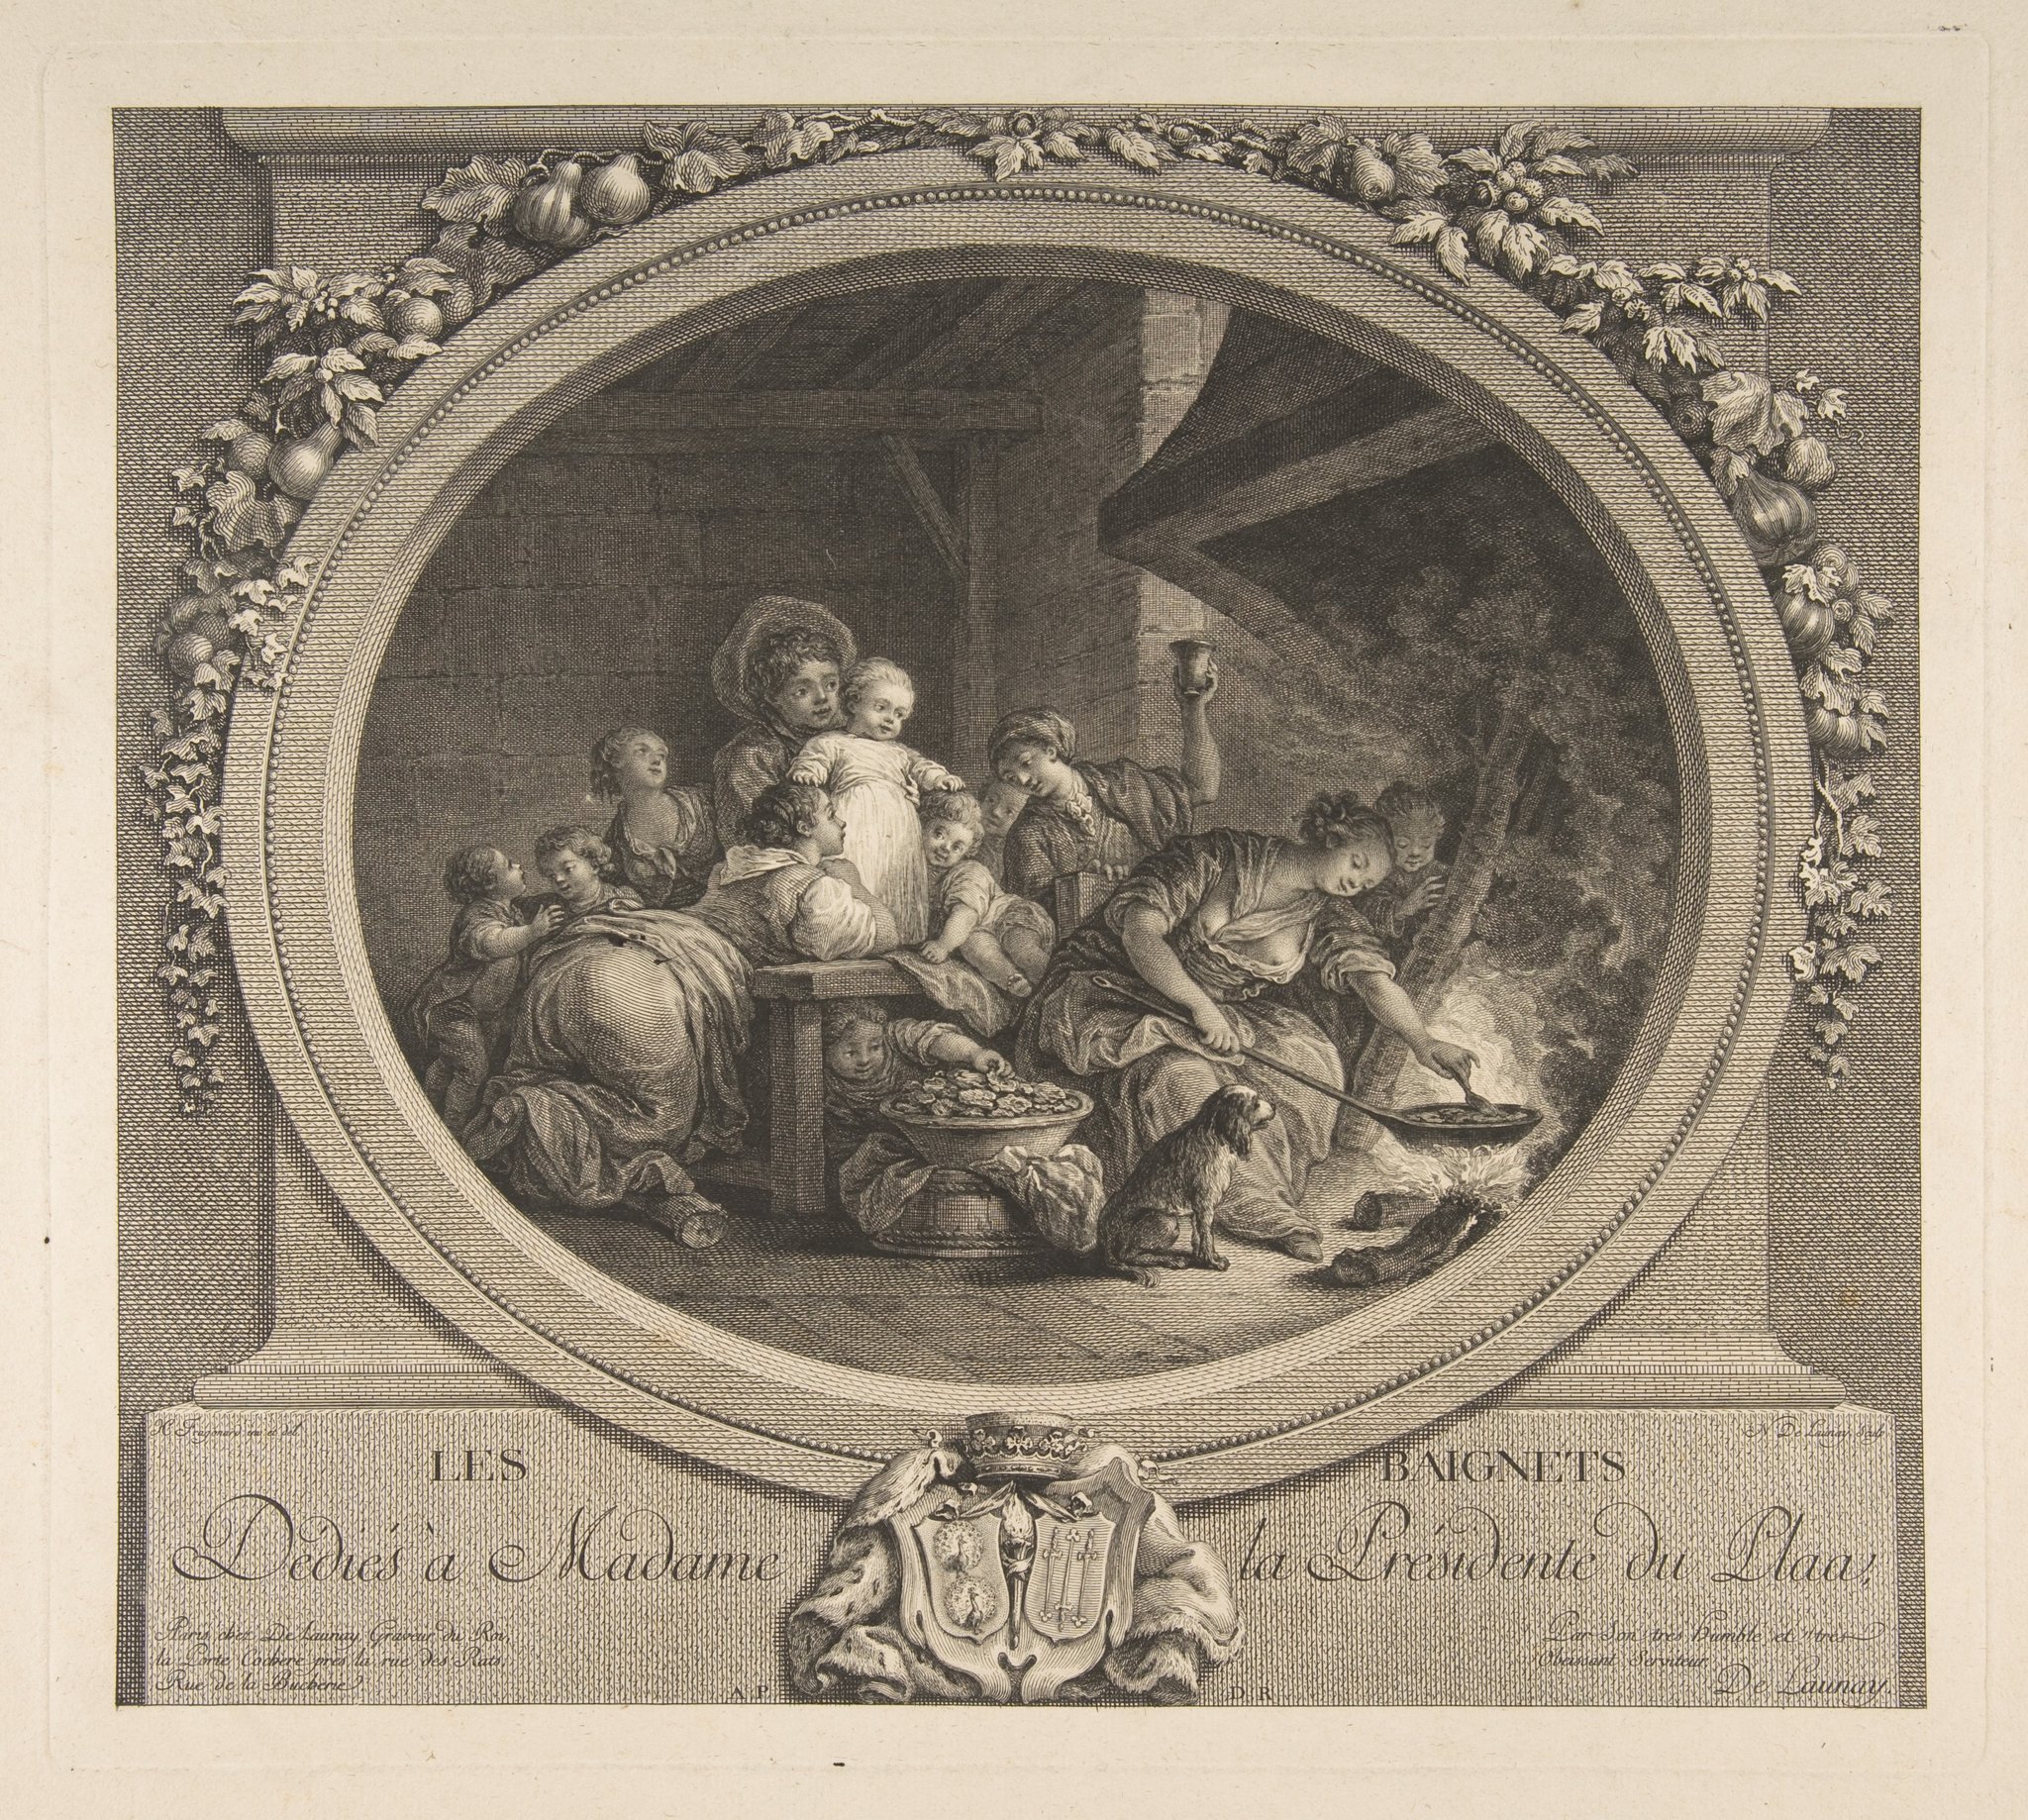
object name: print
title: Les Beignets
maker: jean honoré fragonard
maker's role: artist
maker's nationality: french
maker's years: 1732-1806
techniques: etching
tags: food,children,women,dogs,working